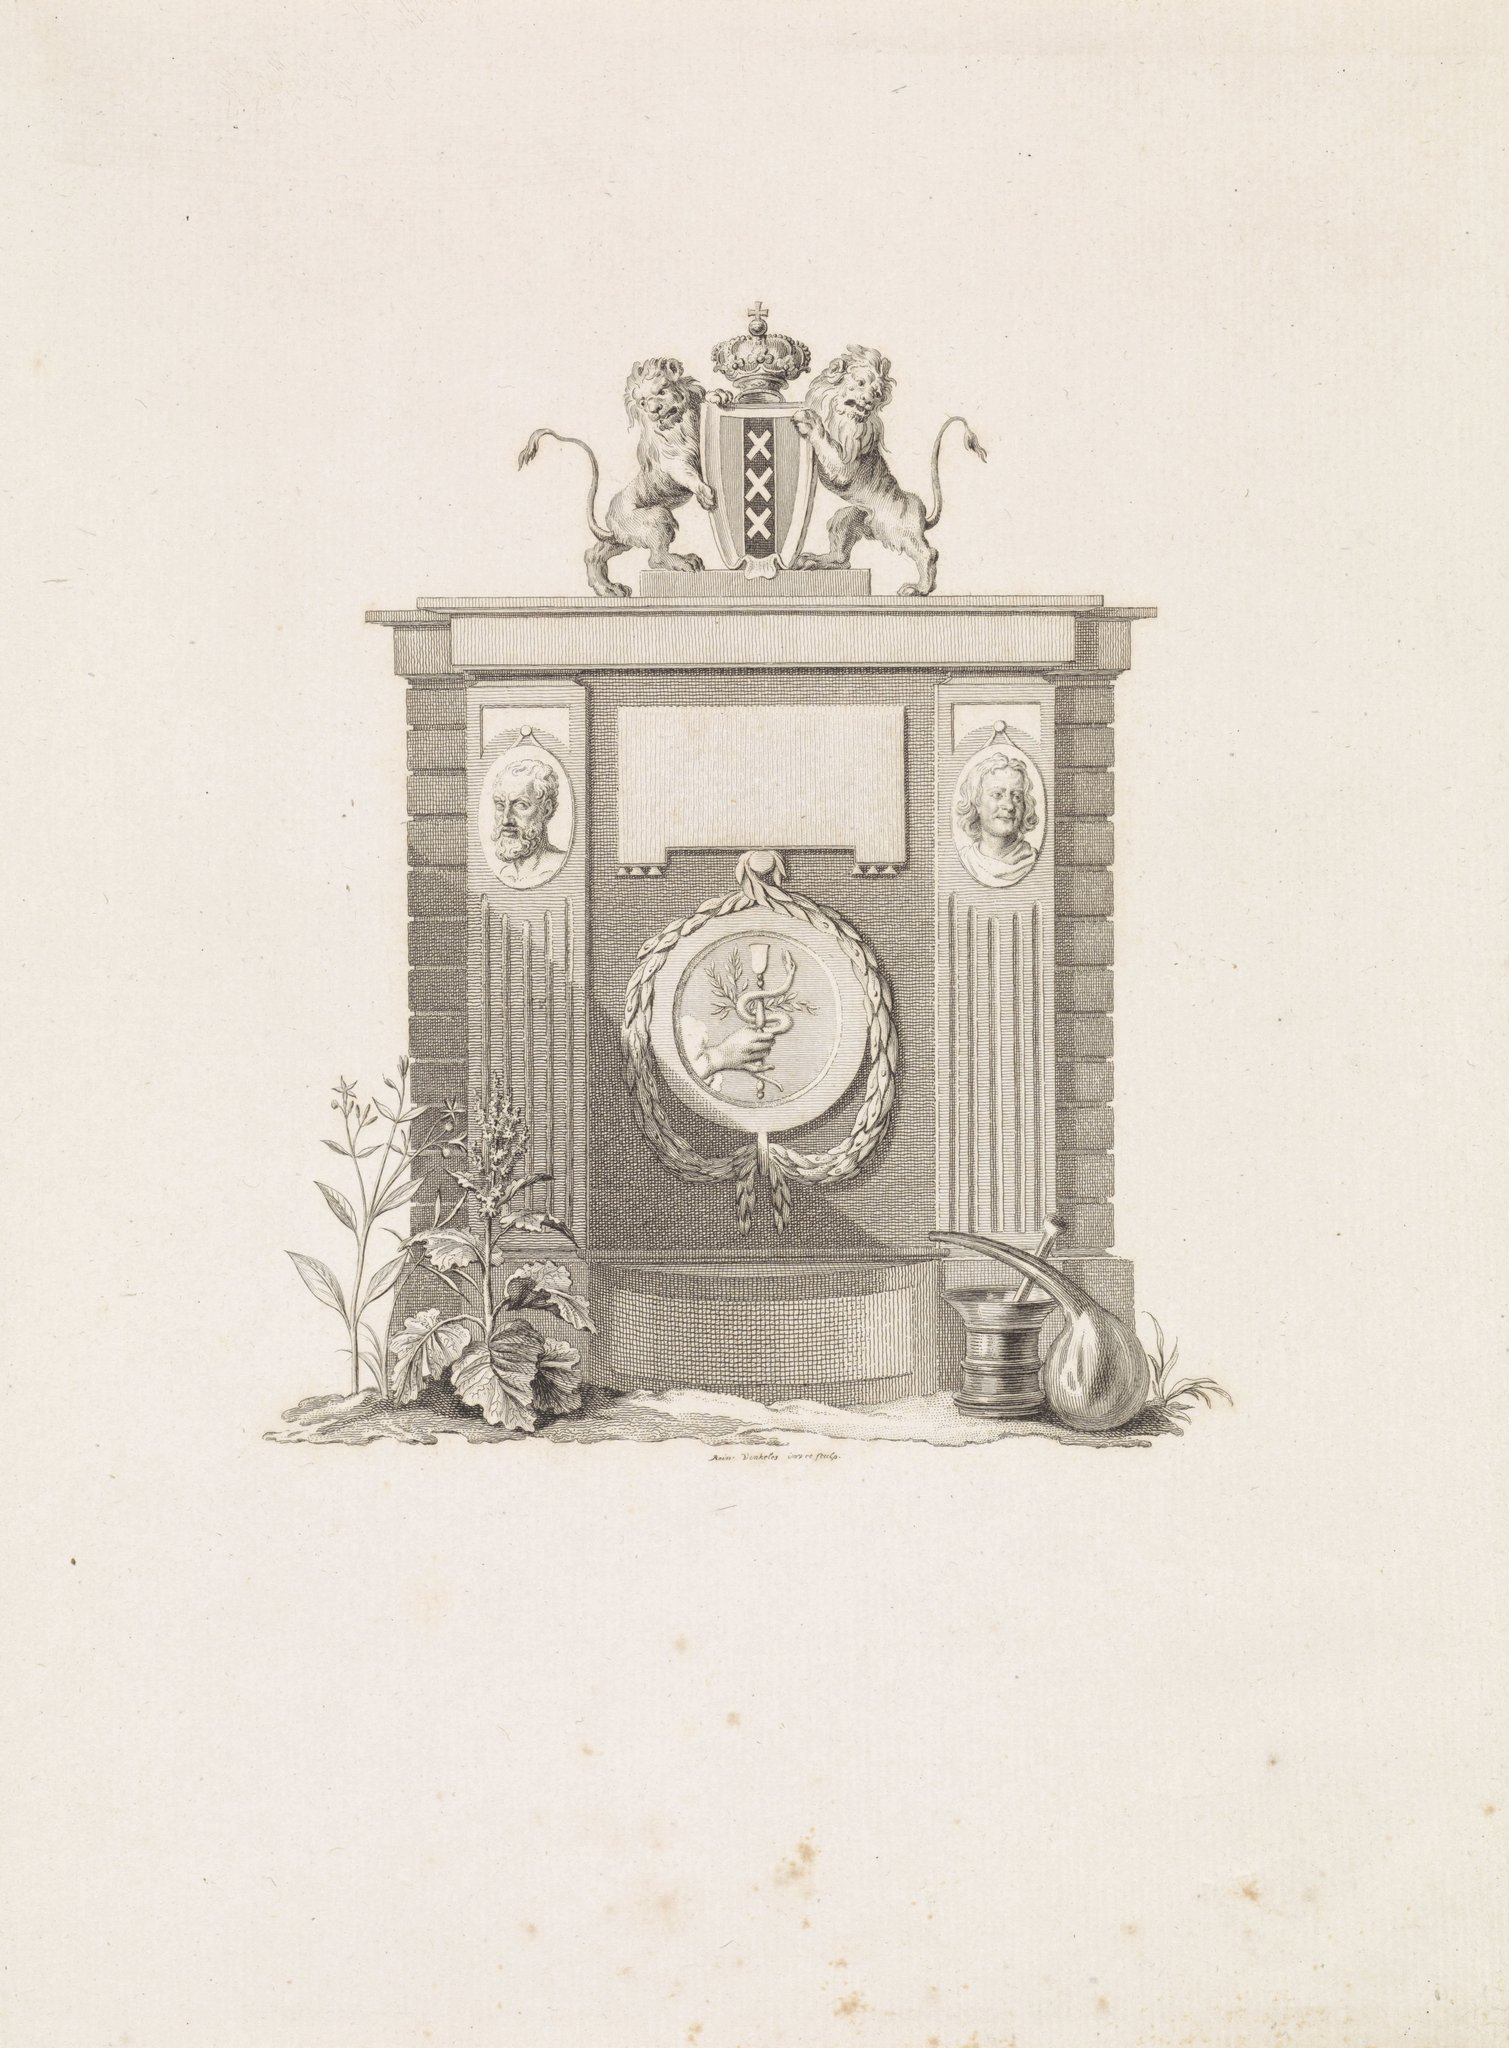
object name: print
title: Monument voor een Amsterdamse apotheker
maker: reinier vinkeles (i)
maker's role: draughtsman, print maker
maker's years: 1741-1816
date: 1751-1816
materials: paper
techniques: engraving, etching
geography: amsterdam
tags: pharmacist, druggist, apothecary; pharmacy, drugstore, dispensing chemist, tools and implements of pharmacist, armorial bearing, heraldry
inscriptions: collector's mark: Lugt 240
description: Monument voor een onbekende Amsterdamse apotheker in de vorm van een steen waarop twee portretten, waarvan een van Theophrastus van Eresus. In het midden van de steen een apothekerssymbool, met kelk en een slang. Voor de steen een vijzel, alambiek en een tabaksplant. Bovenop het monument prijkt het stadswapen van Amsterdam.